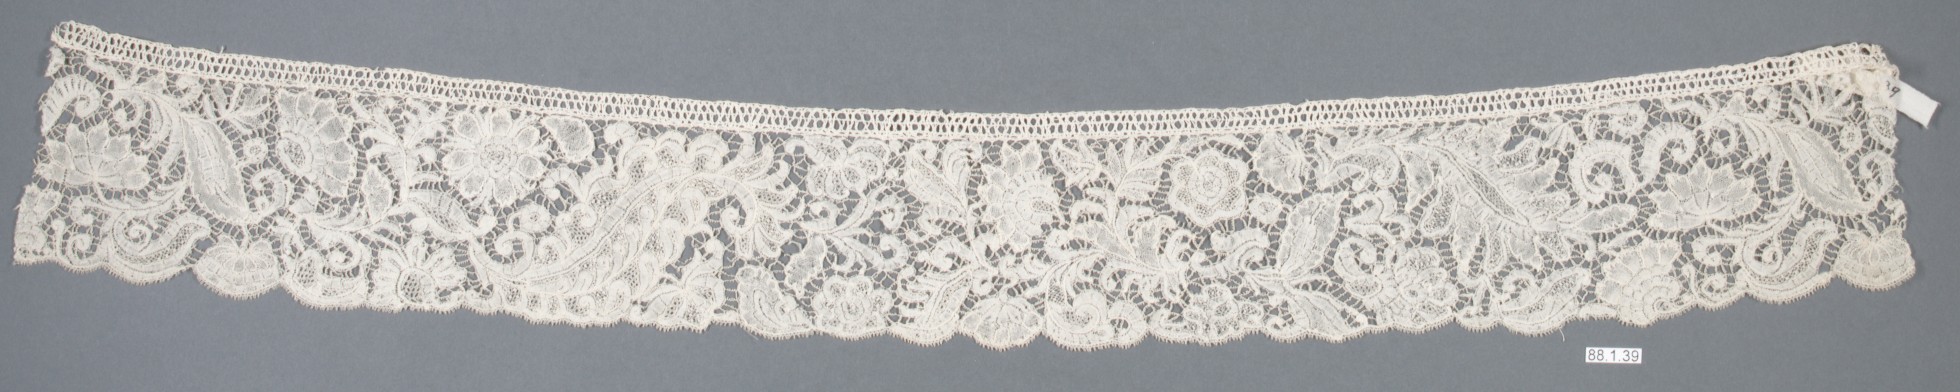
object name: piece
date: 1701-1800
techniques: lace